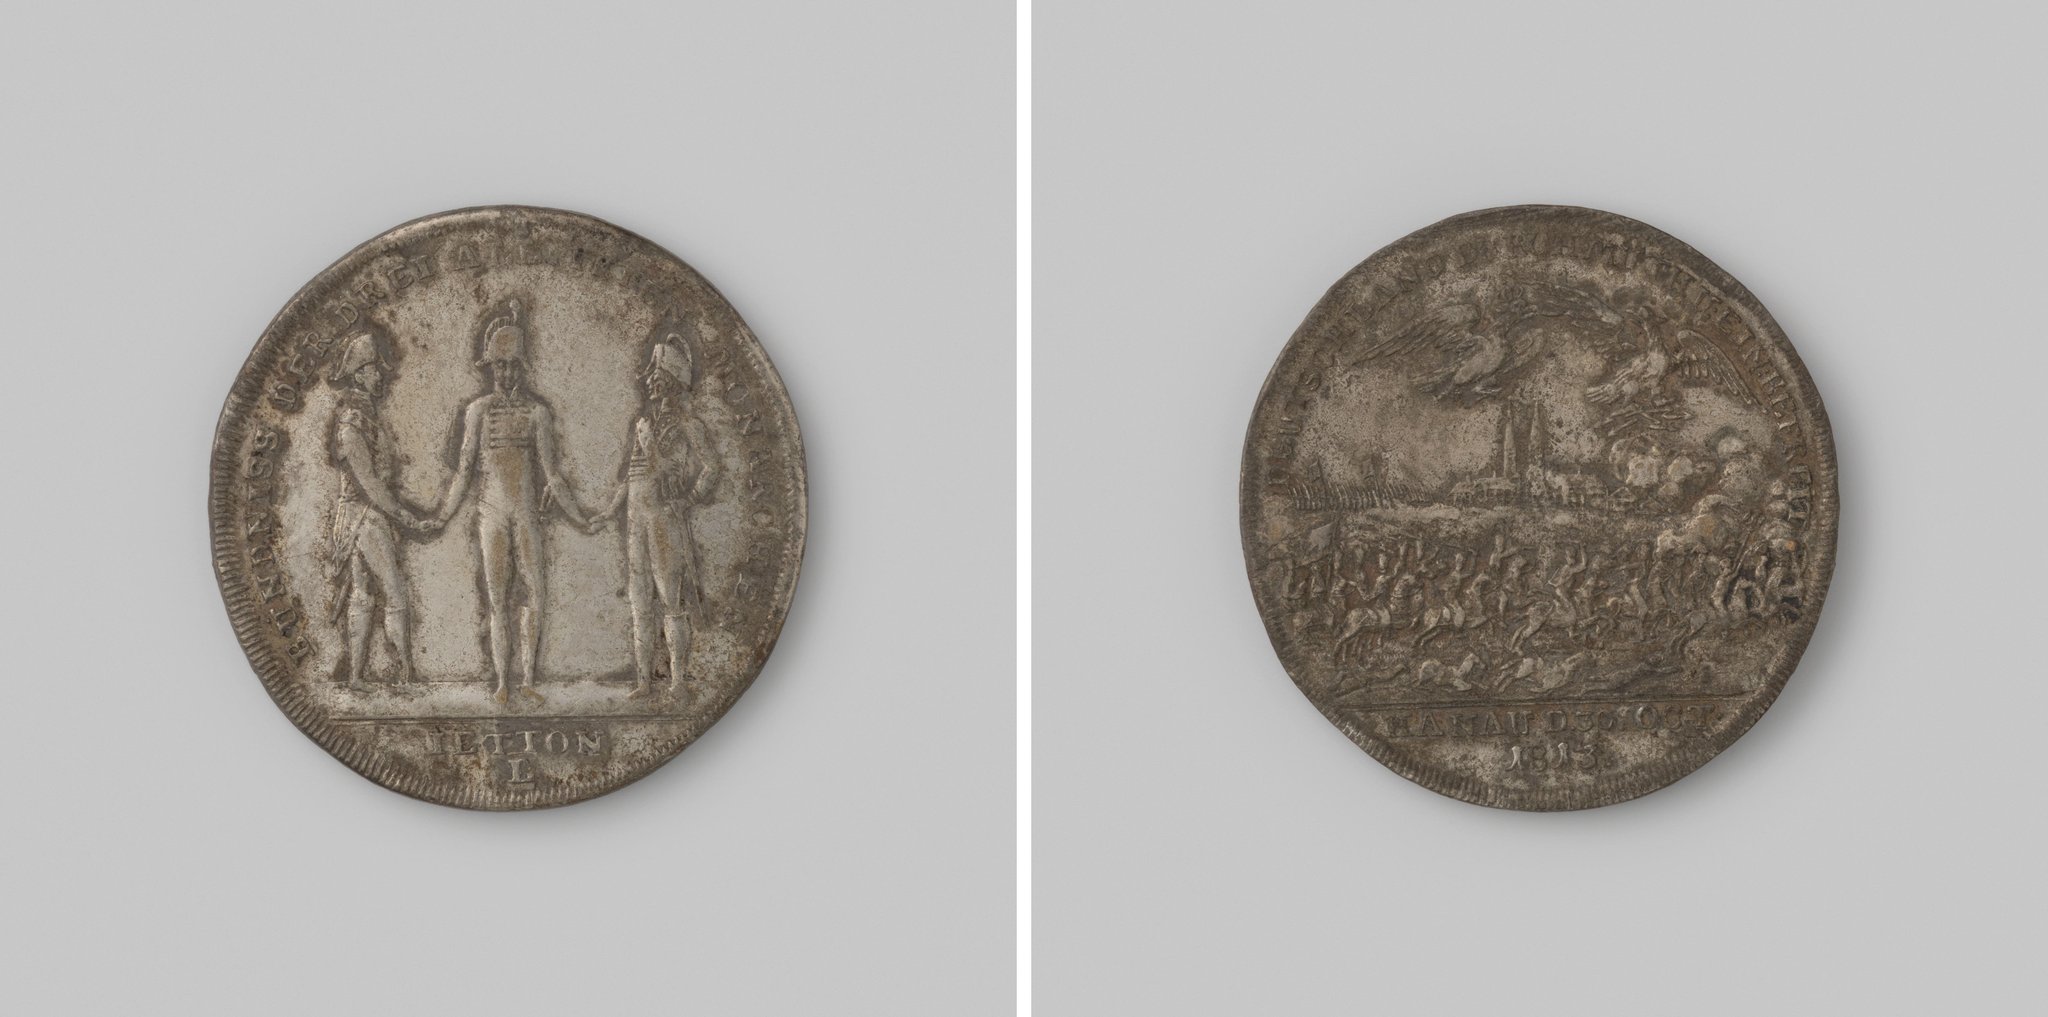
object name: history medal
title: Slag bij Hanau 1813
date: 1813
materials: brass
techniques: striking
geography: nuremberg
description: Zilverkleurige penning, op de voorzijde de vorsten van Engeland, Oostenrijk en Rusland staand, elkaar de hand drukkend, met omschrift en afsnedetekst, op de keerzijde de veldslag met Hanau op de achtergrond, in de lucht vechtende adelaars, met omschrift en afsnedetekst.